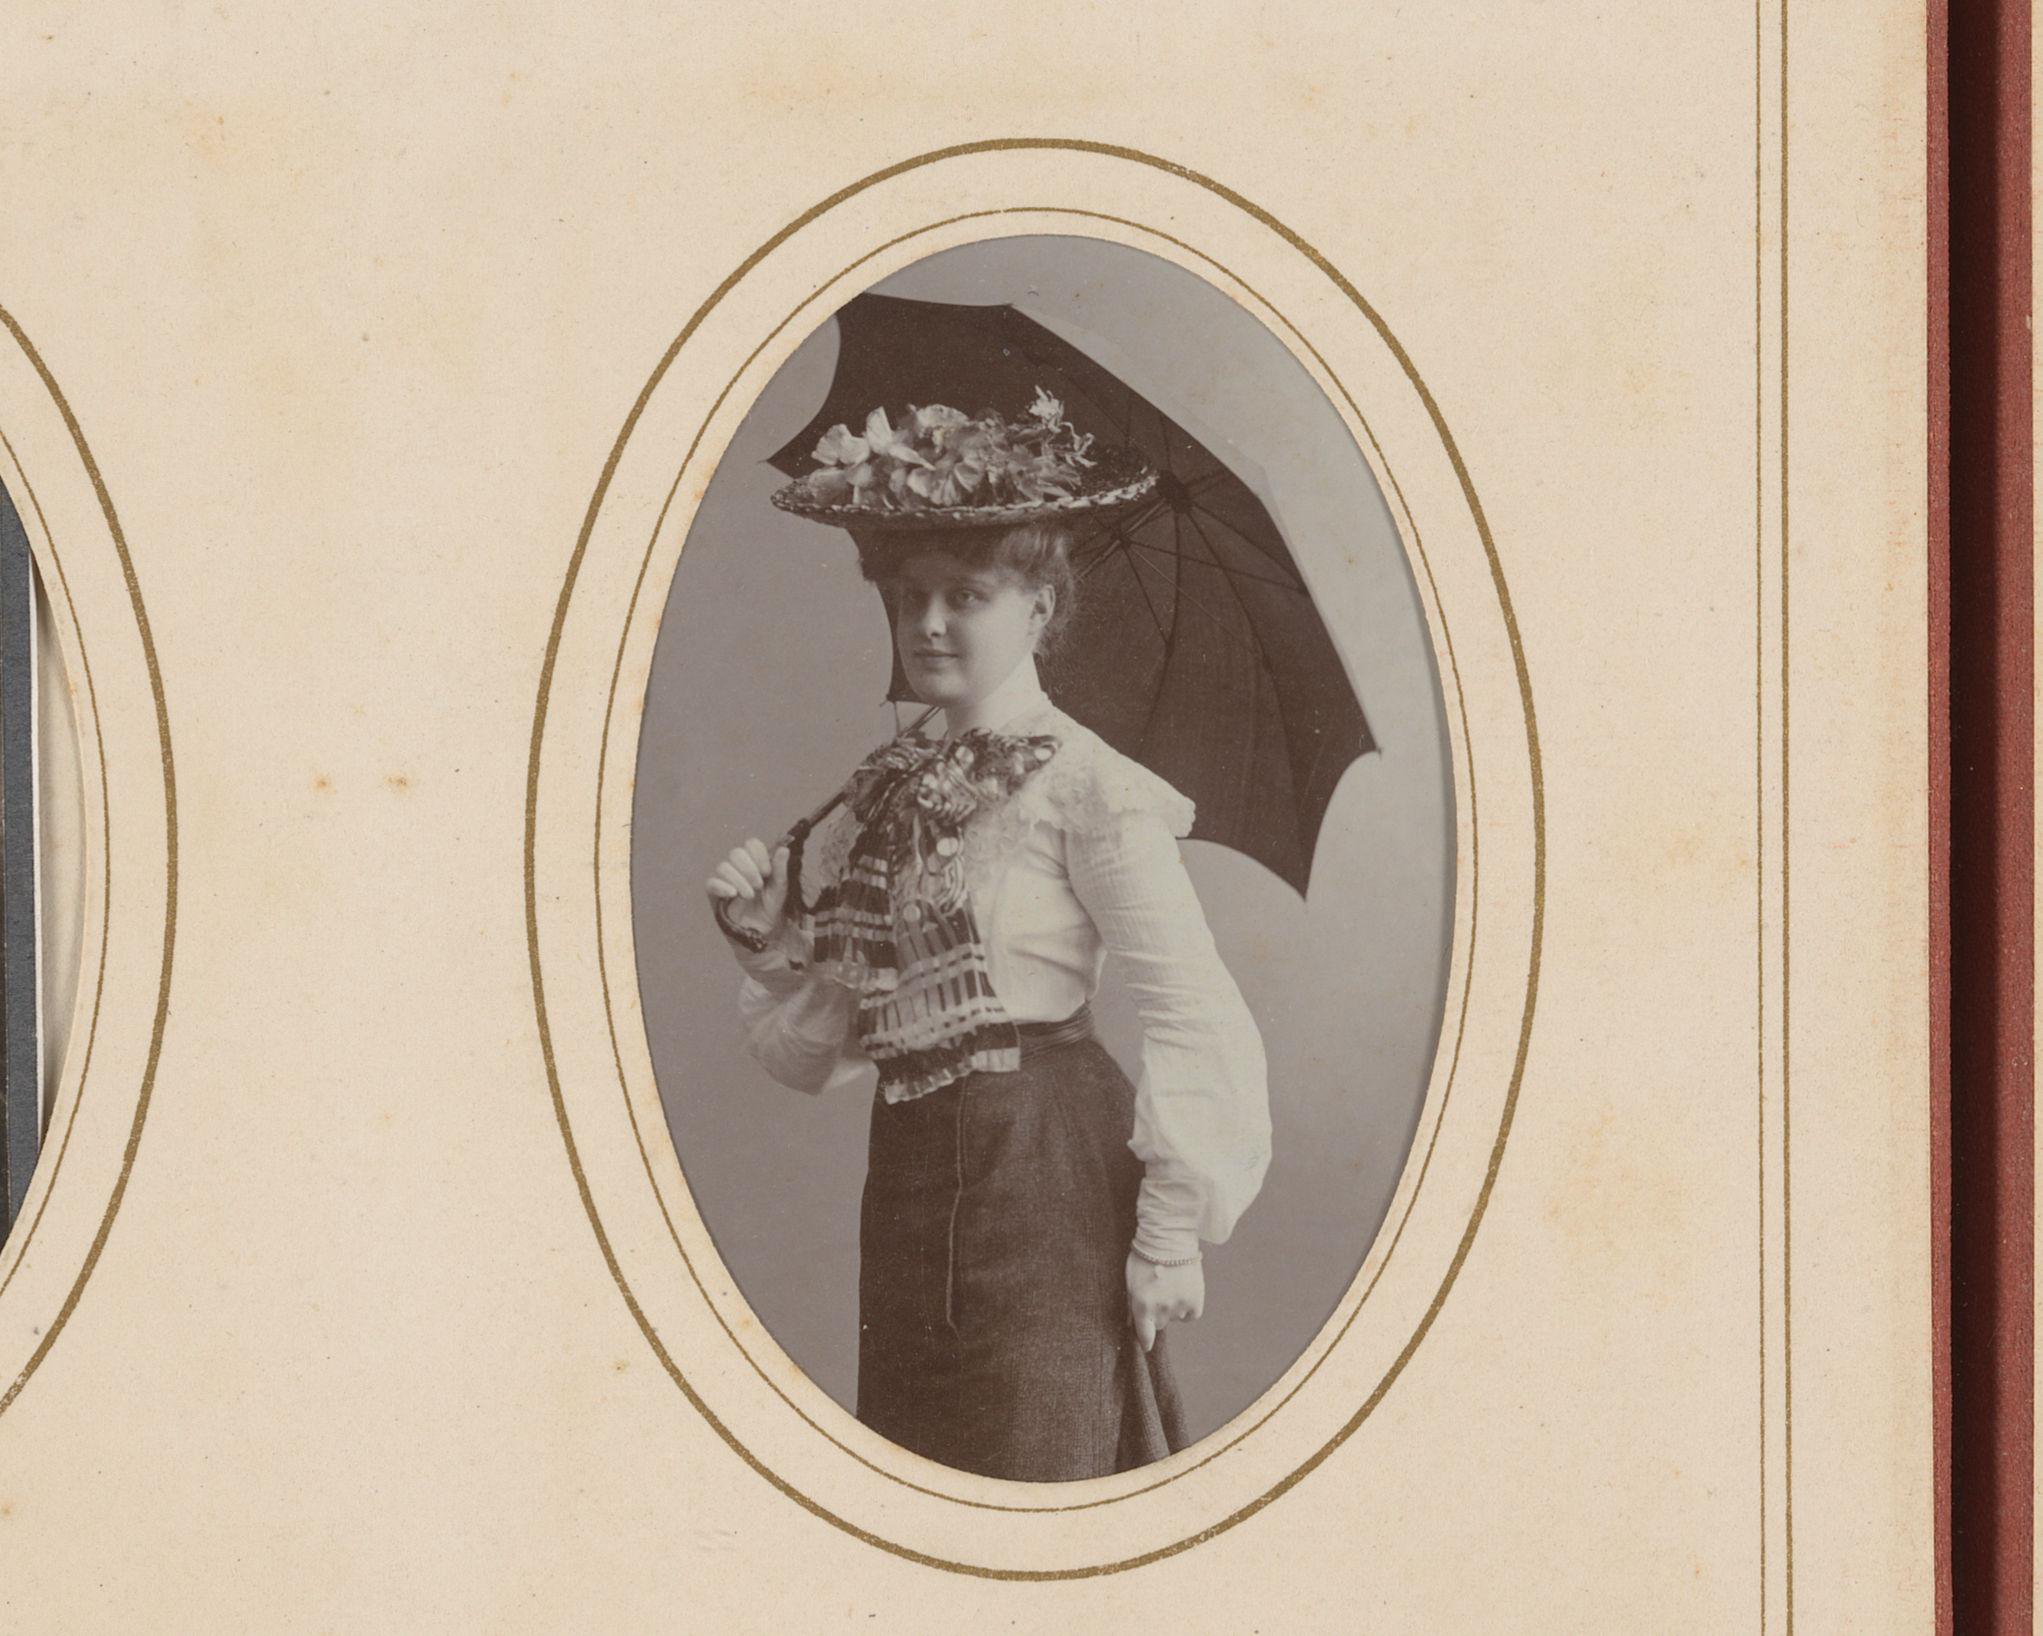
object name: album leaf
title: Portret van een jonge vrouw met hoed en parasol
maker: Anonymous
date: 1895-1920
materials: cardboard, photographic support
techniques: matte daylight collodion silver print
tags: adolescent, young woman, maiden, historical persons - bb - woman, head-gear: hat, umbrella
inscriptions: number: ‘No/ 69298’